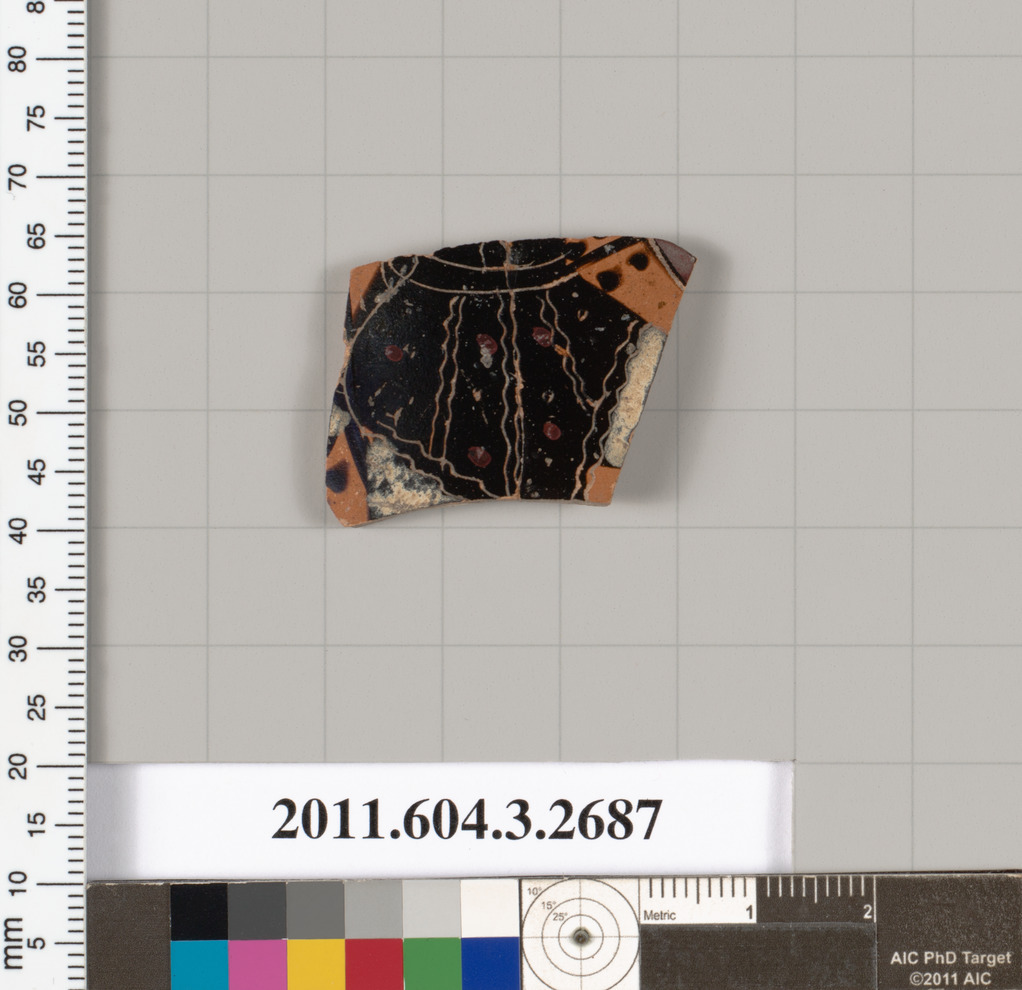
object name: olpe fragment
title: Terracotta fragment of an olpe (jug)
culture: greek, attic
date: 510-500 BCE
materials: terracotta